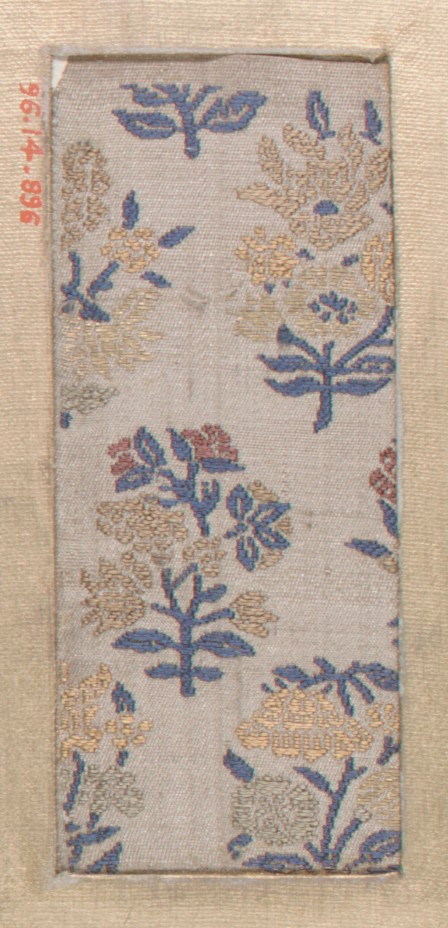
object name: piece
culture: japanese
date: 1701-1900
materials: silk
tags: plants